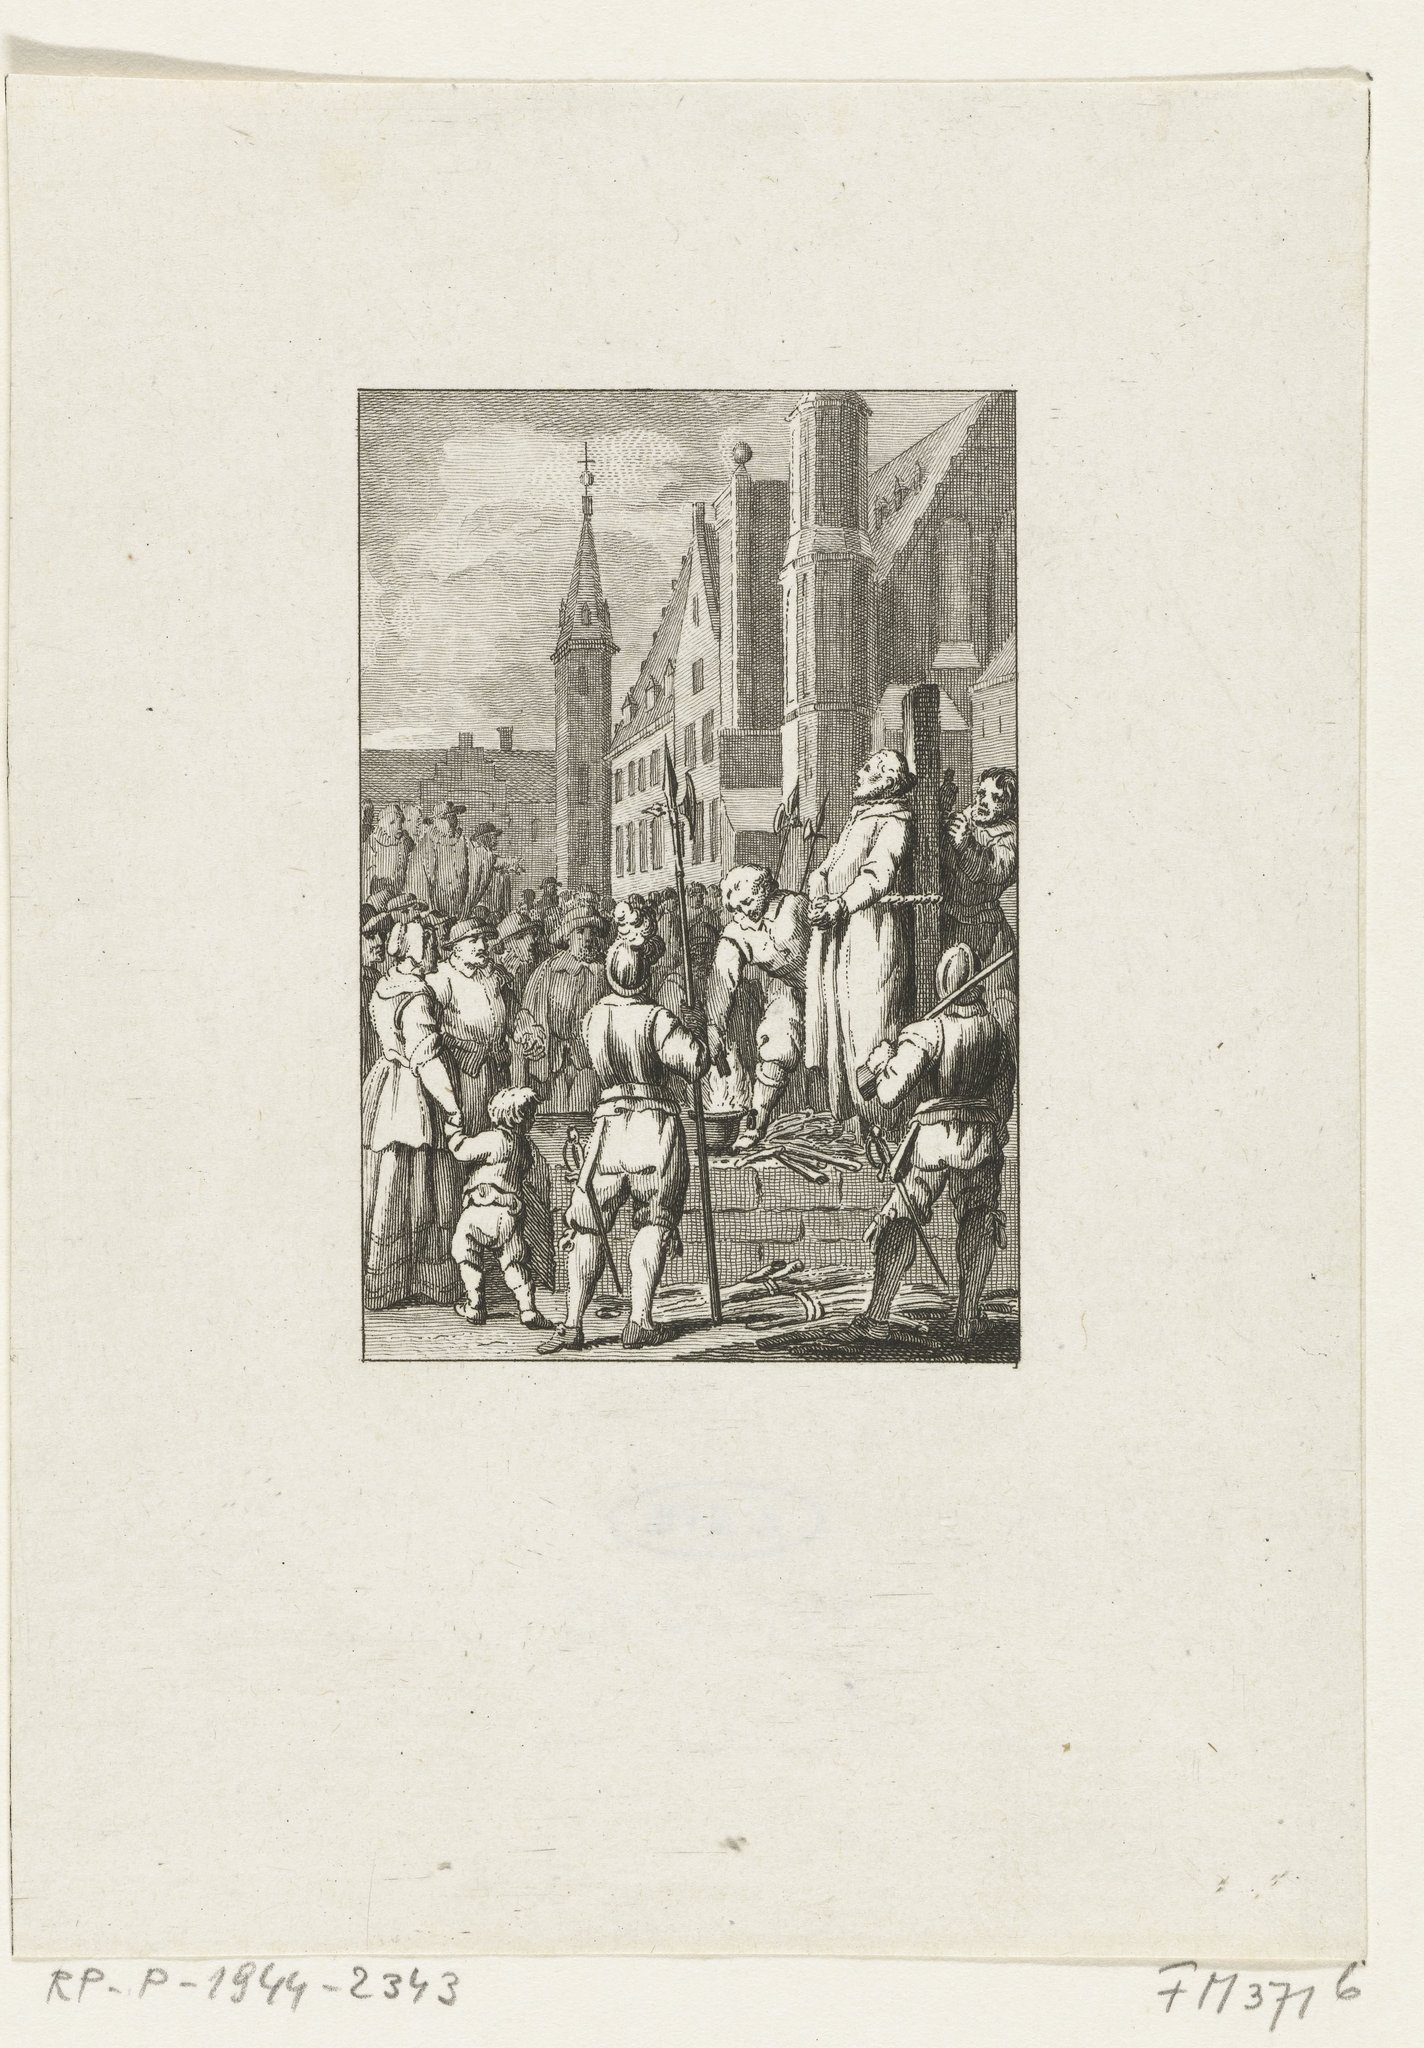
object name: history print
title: Marteldood van Jan de Bakker, 1525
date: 1780-1795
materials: paper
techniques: etching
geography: netherlands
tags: the hague, priest, execution of heretic, e.g. by burning at the stake, 'auto-da-fé', violent death by burning at the stake; pyre, persecution of heretics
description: Illustratie voor: J. Fokke, Geschiedenissen der Vereenigde Nederlanden voor de vaderlandsche jeugd, Johannes Allart, Amsterdam 1783-1795, 25 delen, dl. III, pl. VI. Staat vóór de letter.